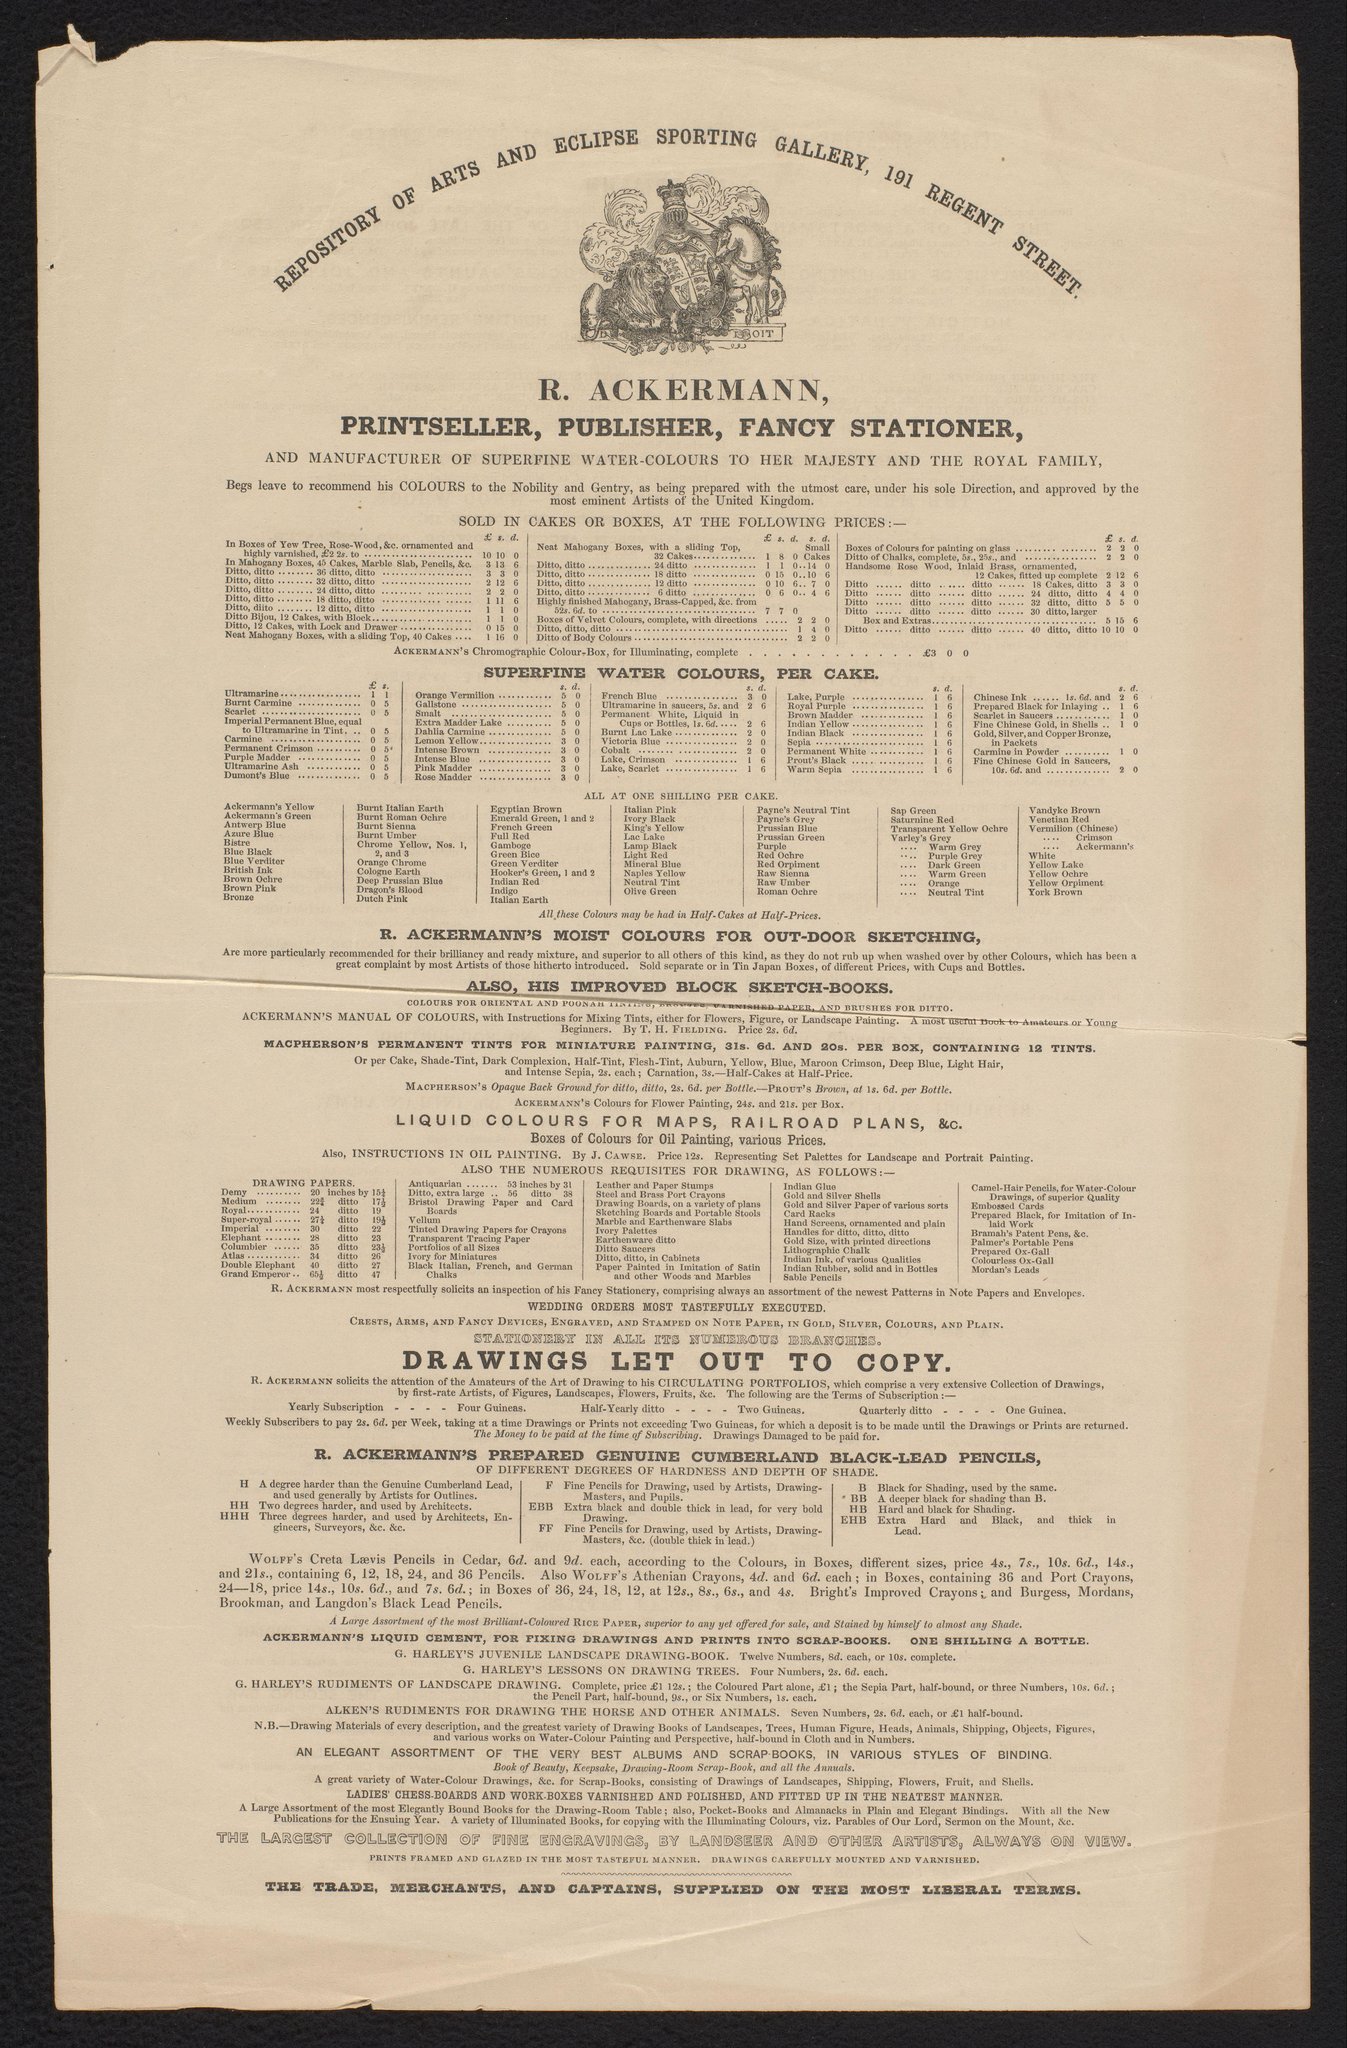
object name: print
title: Repository of Arts and Eclipse Sporting Gallery, 191 Regent Street. R. Ackermann, Printseller, Publisher, Fancy Stationer, and Manufacturer of Superfine Water-colours to Her Majesty and the Royal Family, Begs Leave to Recommend His Colours to the Nobility and Gentry, (...)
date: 1825-1906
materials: paper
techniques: letterpress printing, engraving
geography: london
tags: device (as symbol of the state, etc.), printed matter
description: Reclamebiljet voor de producten die Rudolph Ackermann jr. verkocht, zoals aquarel en aanverwante producten zoals schetsboeken. Op het verso een aankondiging van de door Ackermann uitgegeven prenten.